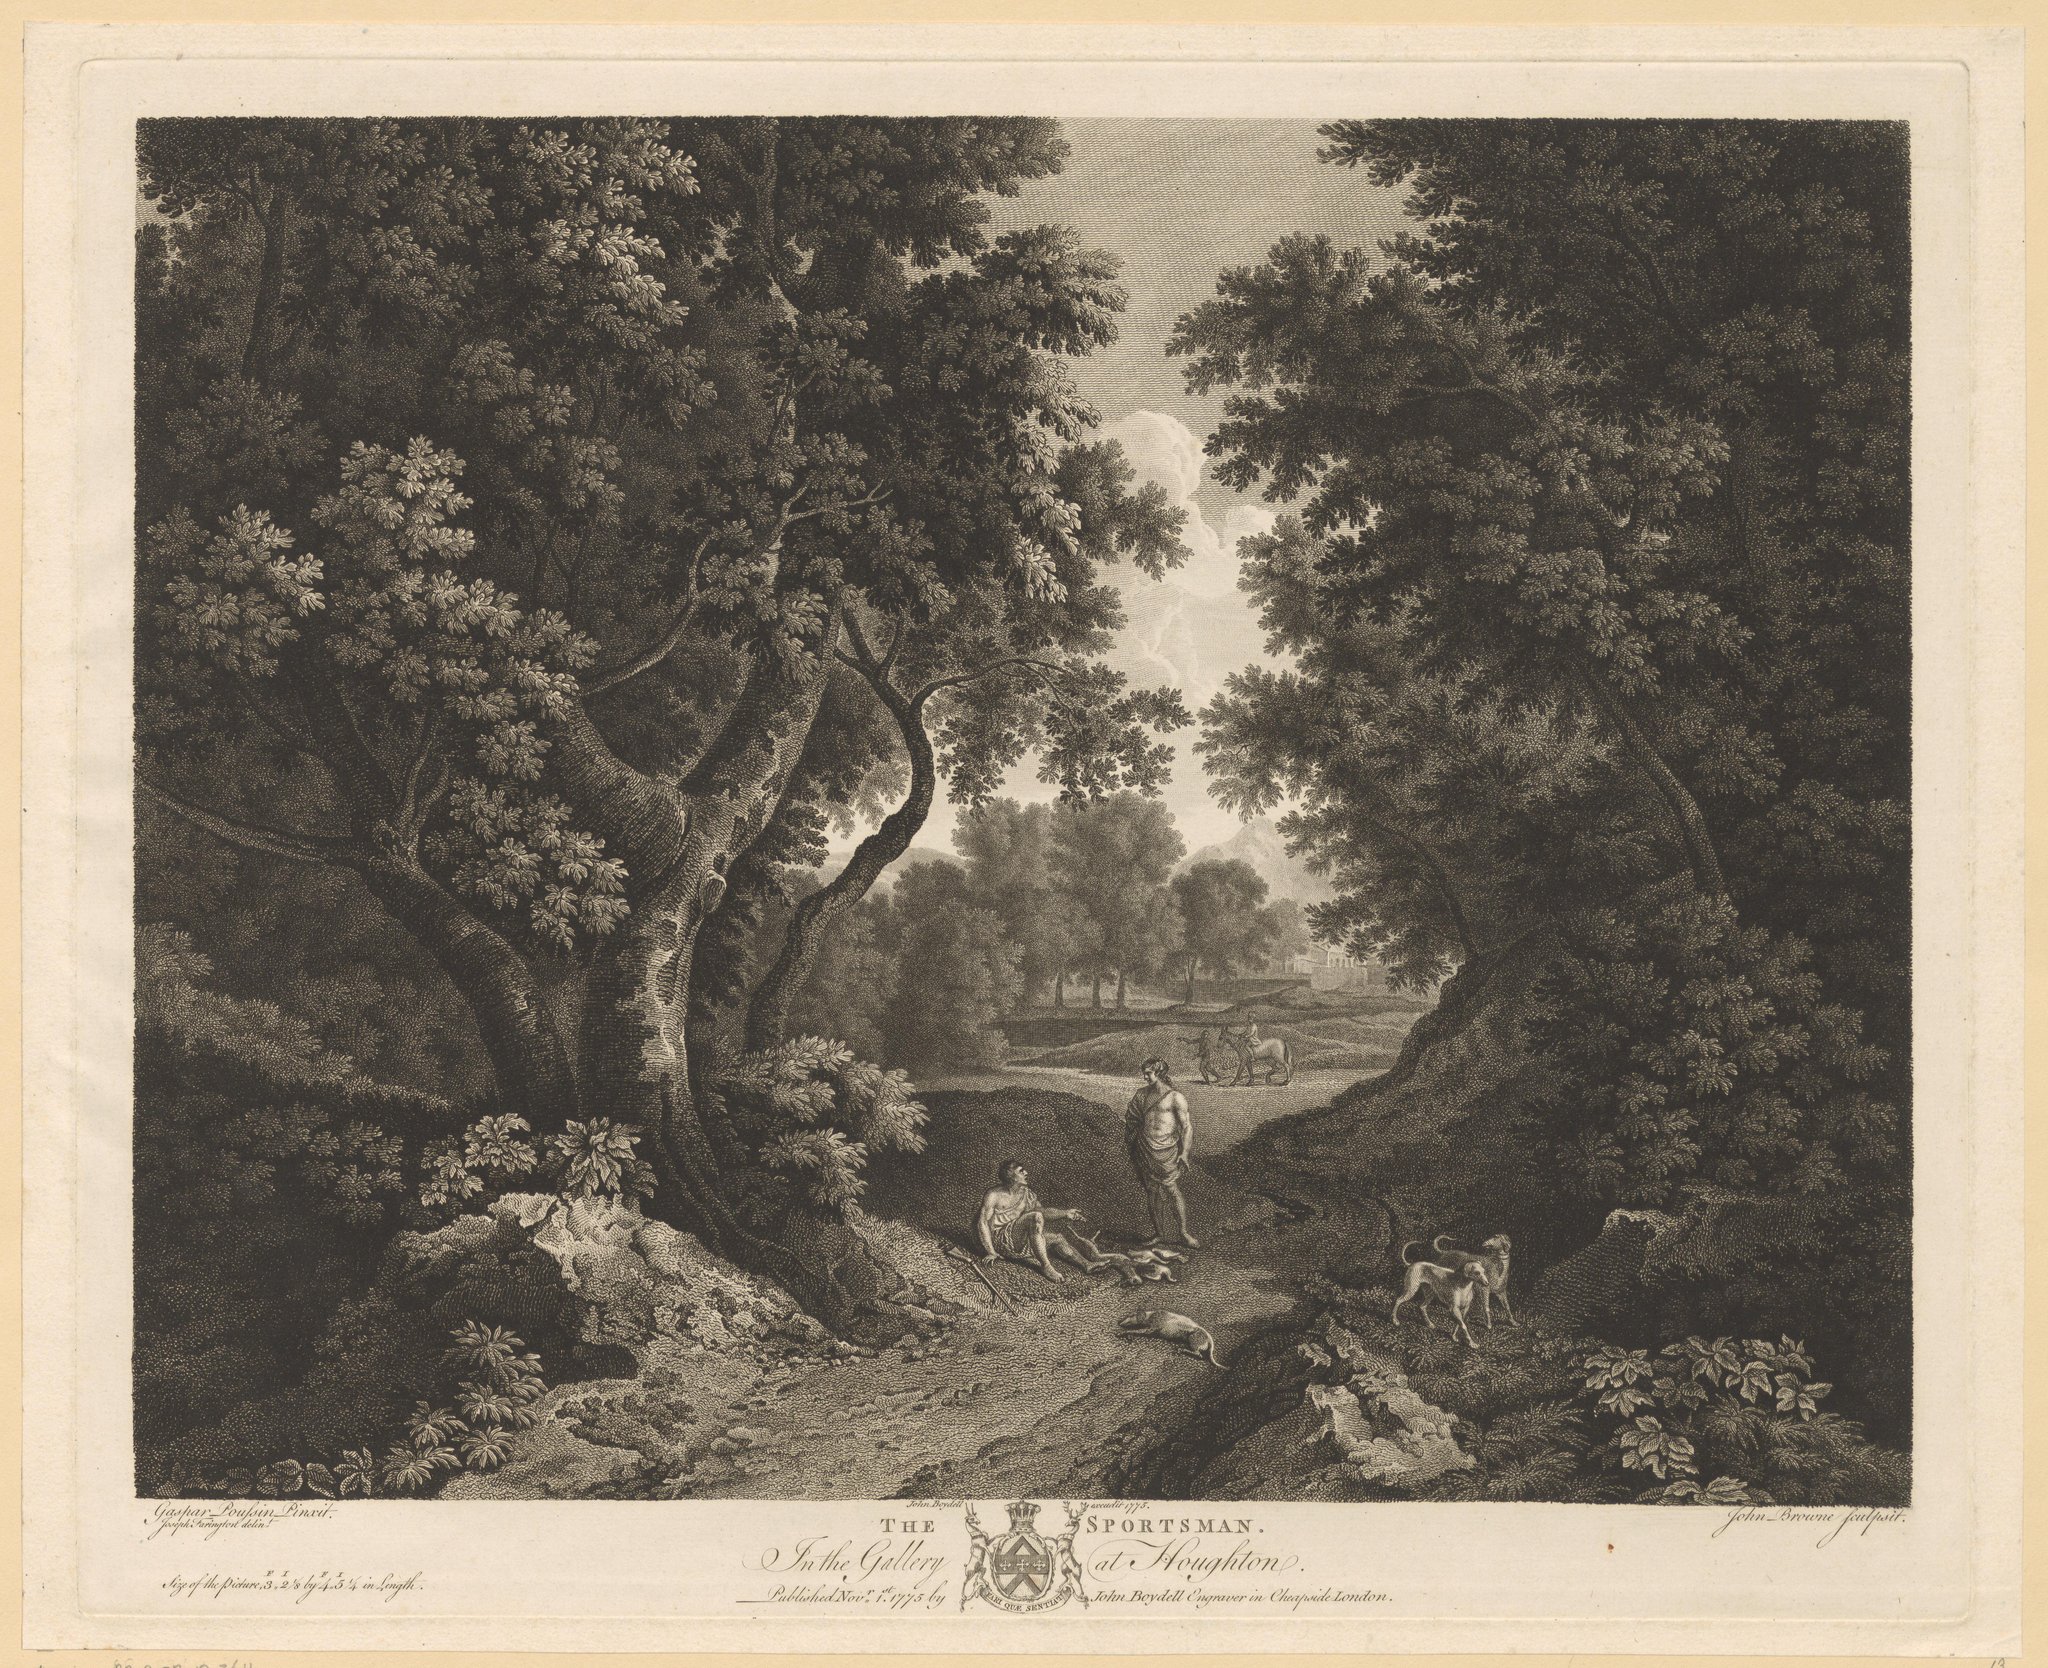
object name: print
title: Schilderijen uit The Houghton Gallery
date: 1711-1775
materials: paper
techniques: engraving, etching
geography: london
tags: trees, hunting dogs, bird hunting, hunters resting during the hunt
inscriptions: collector's mark: Lugt 12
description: Prent is onderdeel van een serie van 162 prenten naar schilderijen uit de collectie van Sir Robert Walpole in Houghton, op initiatief van uitgever John Boydell.